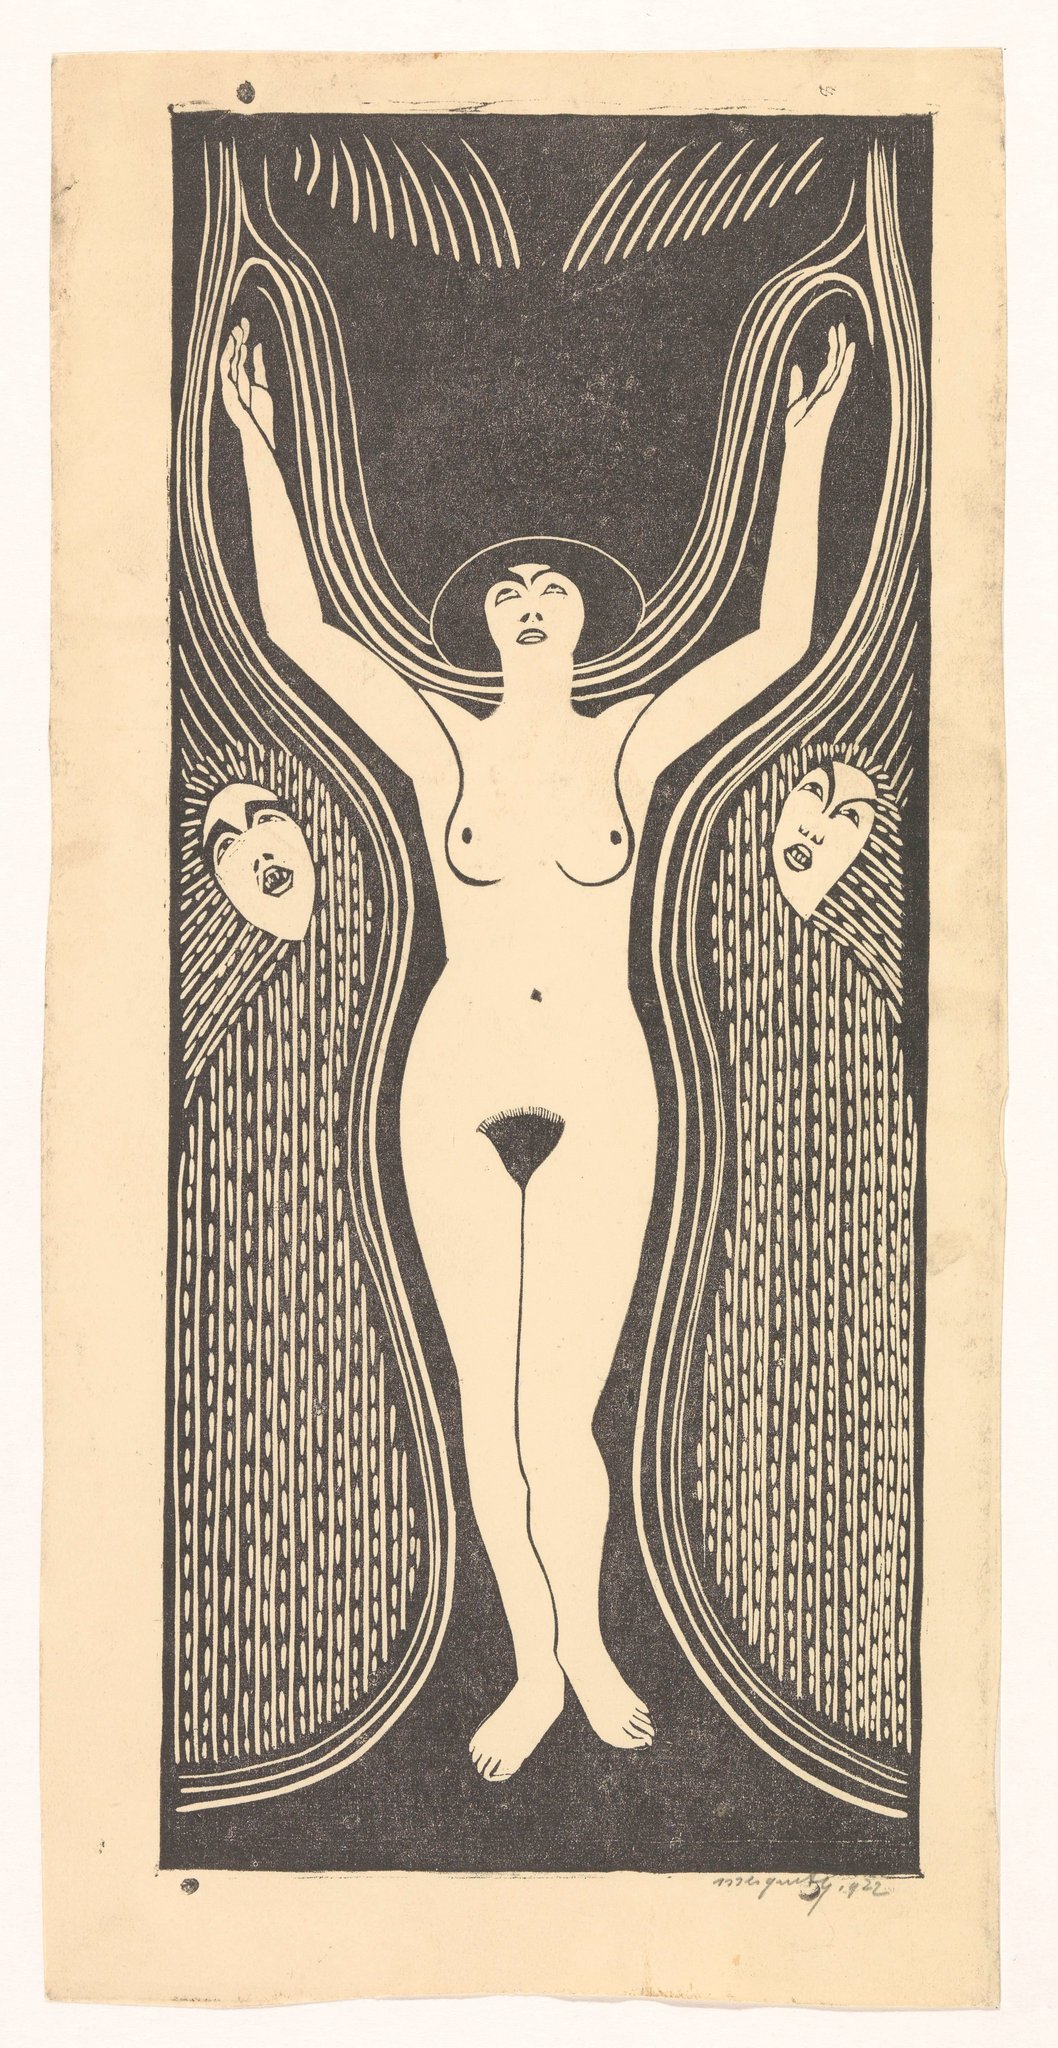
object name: print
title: Extase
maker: samuel jessurun de mesquita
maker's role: draughtsman, print maker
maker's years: 1868-1944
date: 1922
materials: paper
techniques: woodcut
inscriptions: signature and date: ‘mesquita 1922’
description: Staande naakte vrouw met geheven armen met naast haar twee gezichten.